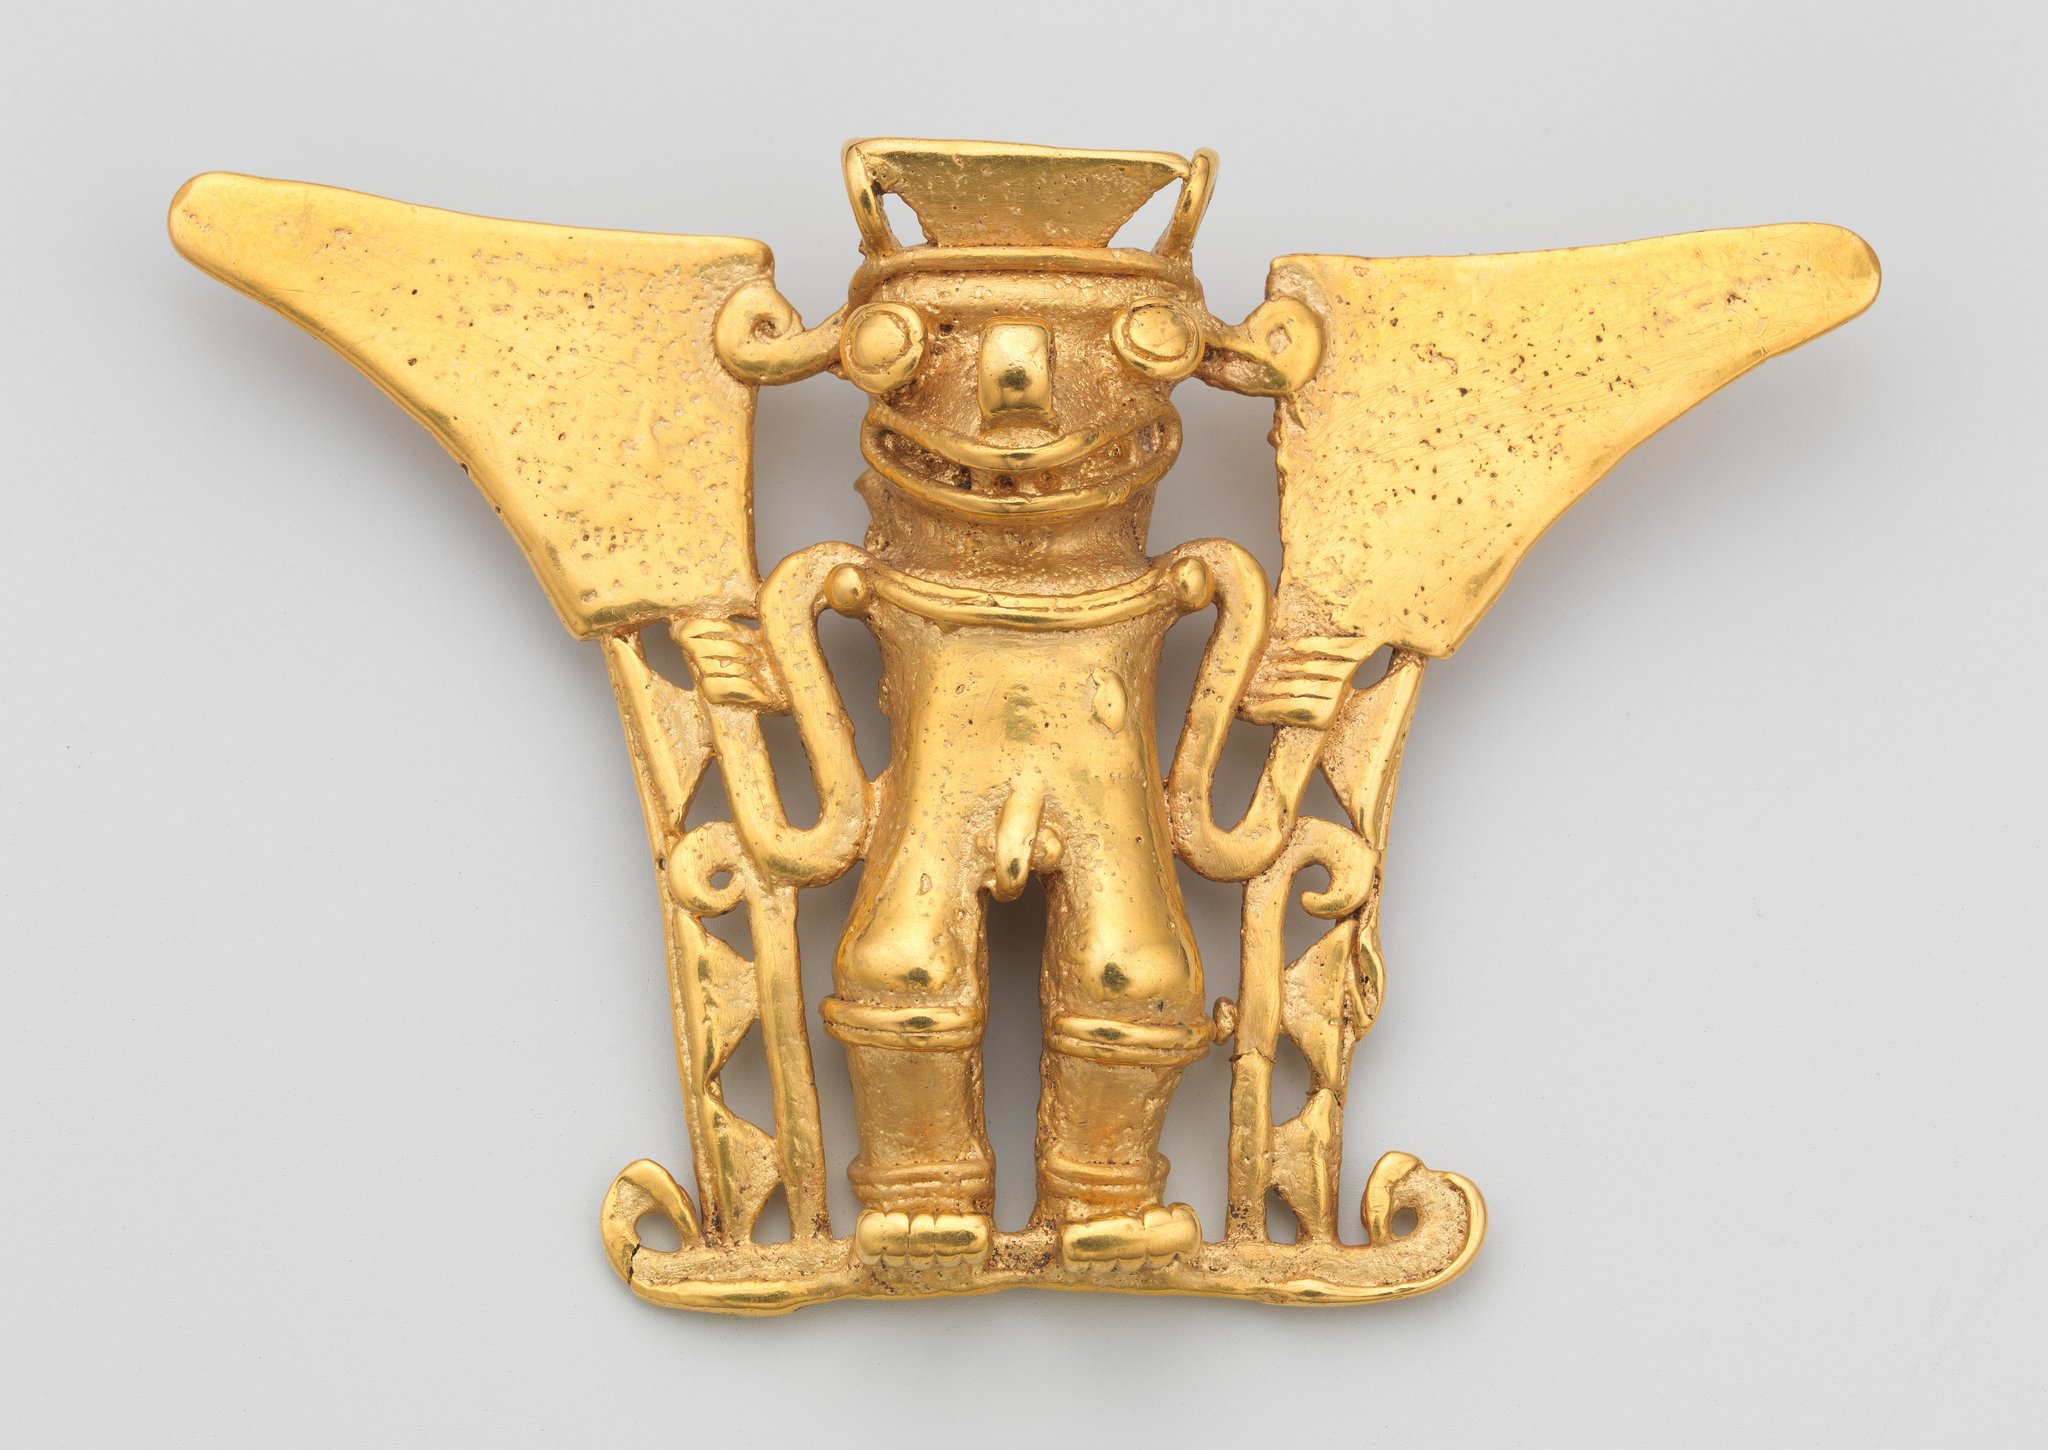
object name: pendant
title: Bat-Head Figure Pendant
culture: diquís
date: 1201-1600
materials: gold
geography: costa rica